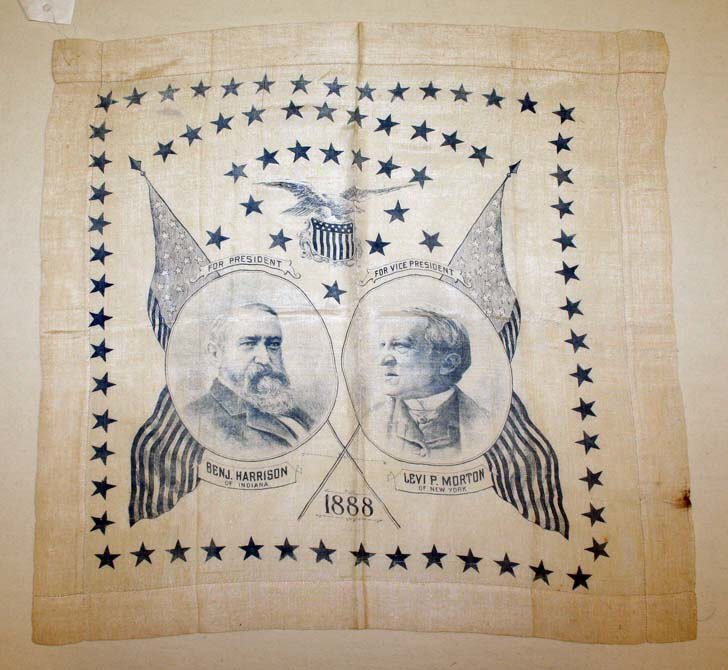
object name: handkerchief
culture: american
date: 1888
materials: silk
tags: elections,men,portraits,politics